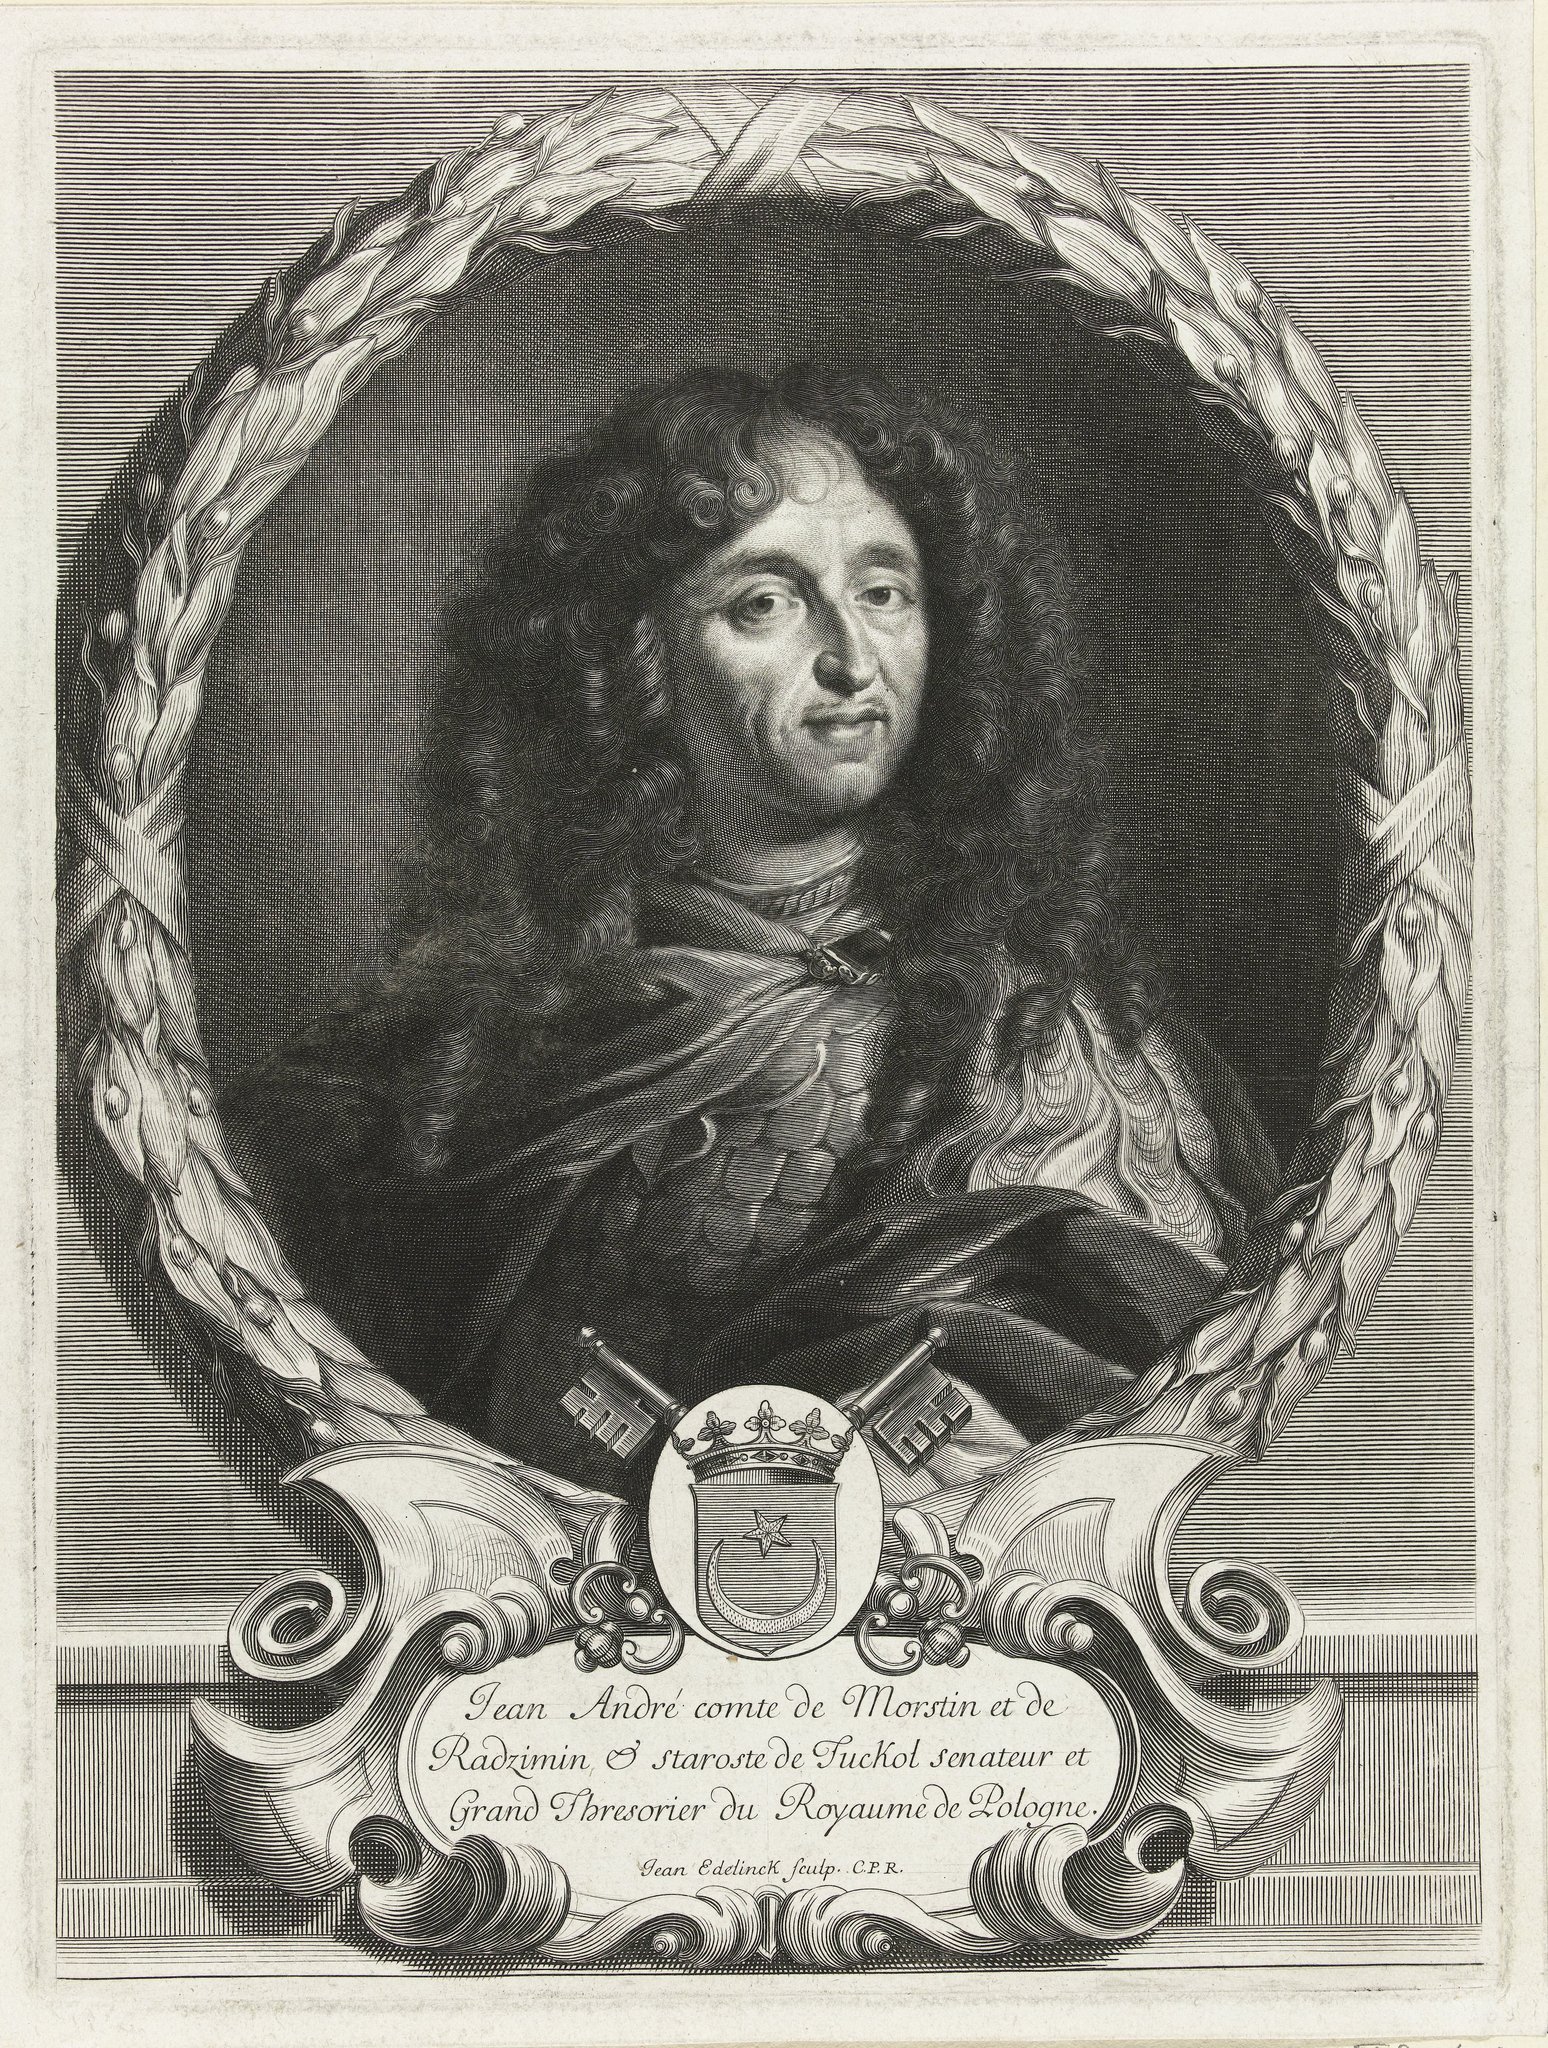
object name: print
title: Jean André compte de Morstin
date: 1666-1680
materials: paper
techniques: engraving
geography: paris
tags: jan andrzej morsztyn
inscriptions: collector's mark: Lugt 240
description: Portret van de Poolse dichter en schatbewaarder Jan Andrzej Morsztyn (1621-1693), afgebeeld in een omlijsting van laurierbladeren. Onderaan de omlijsting een cartouche met wapen en een Franse tekst van drie regels.